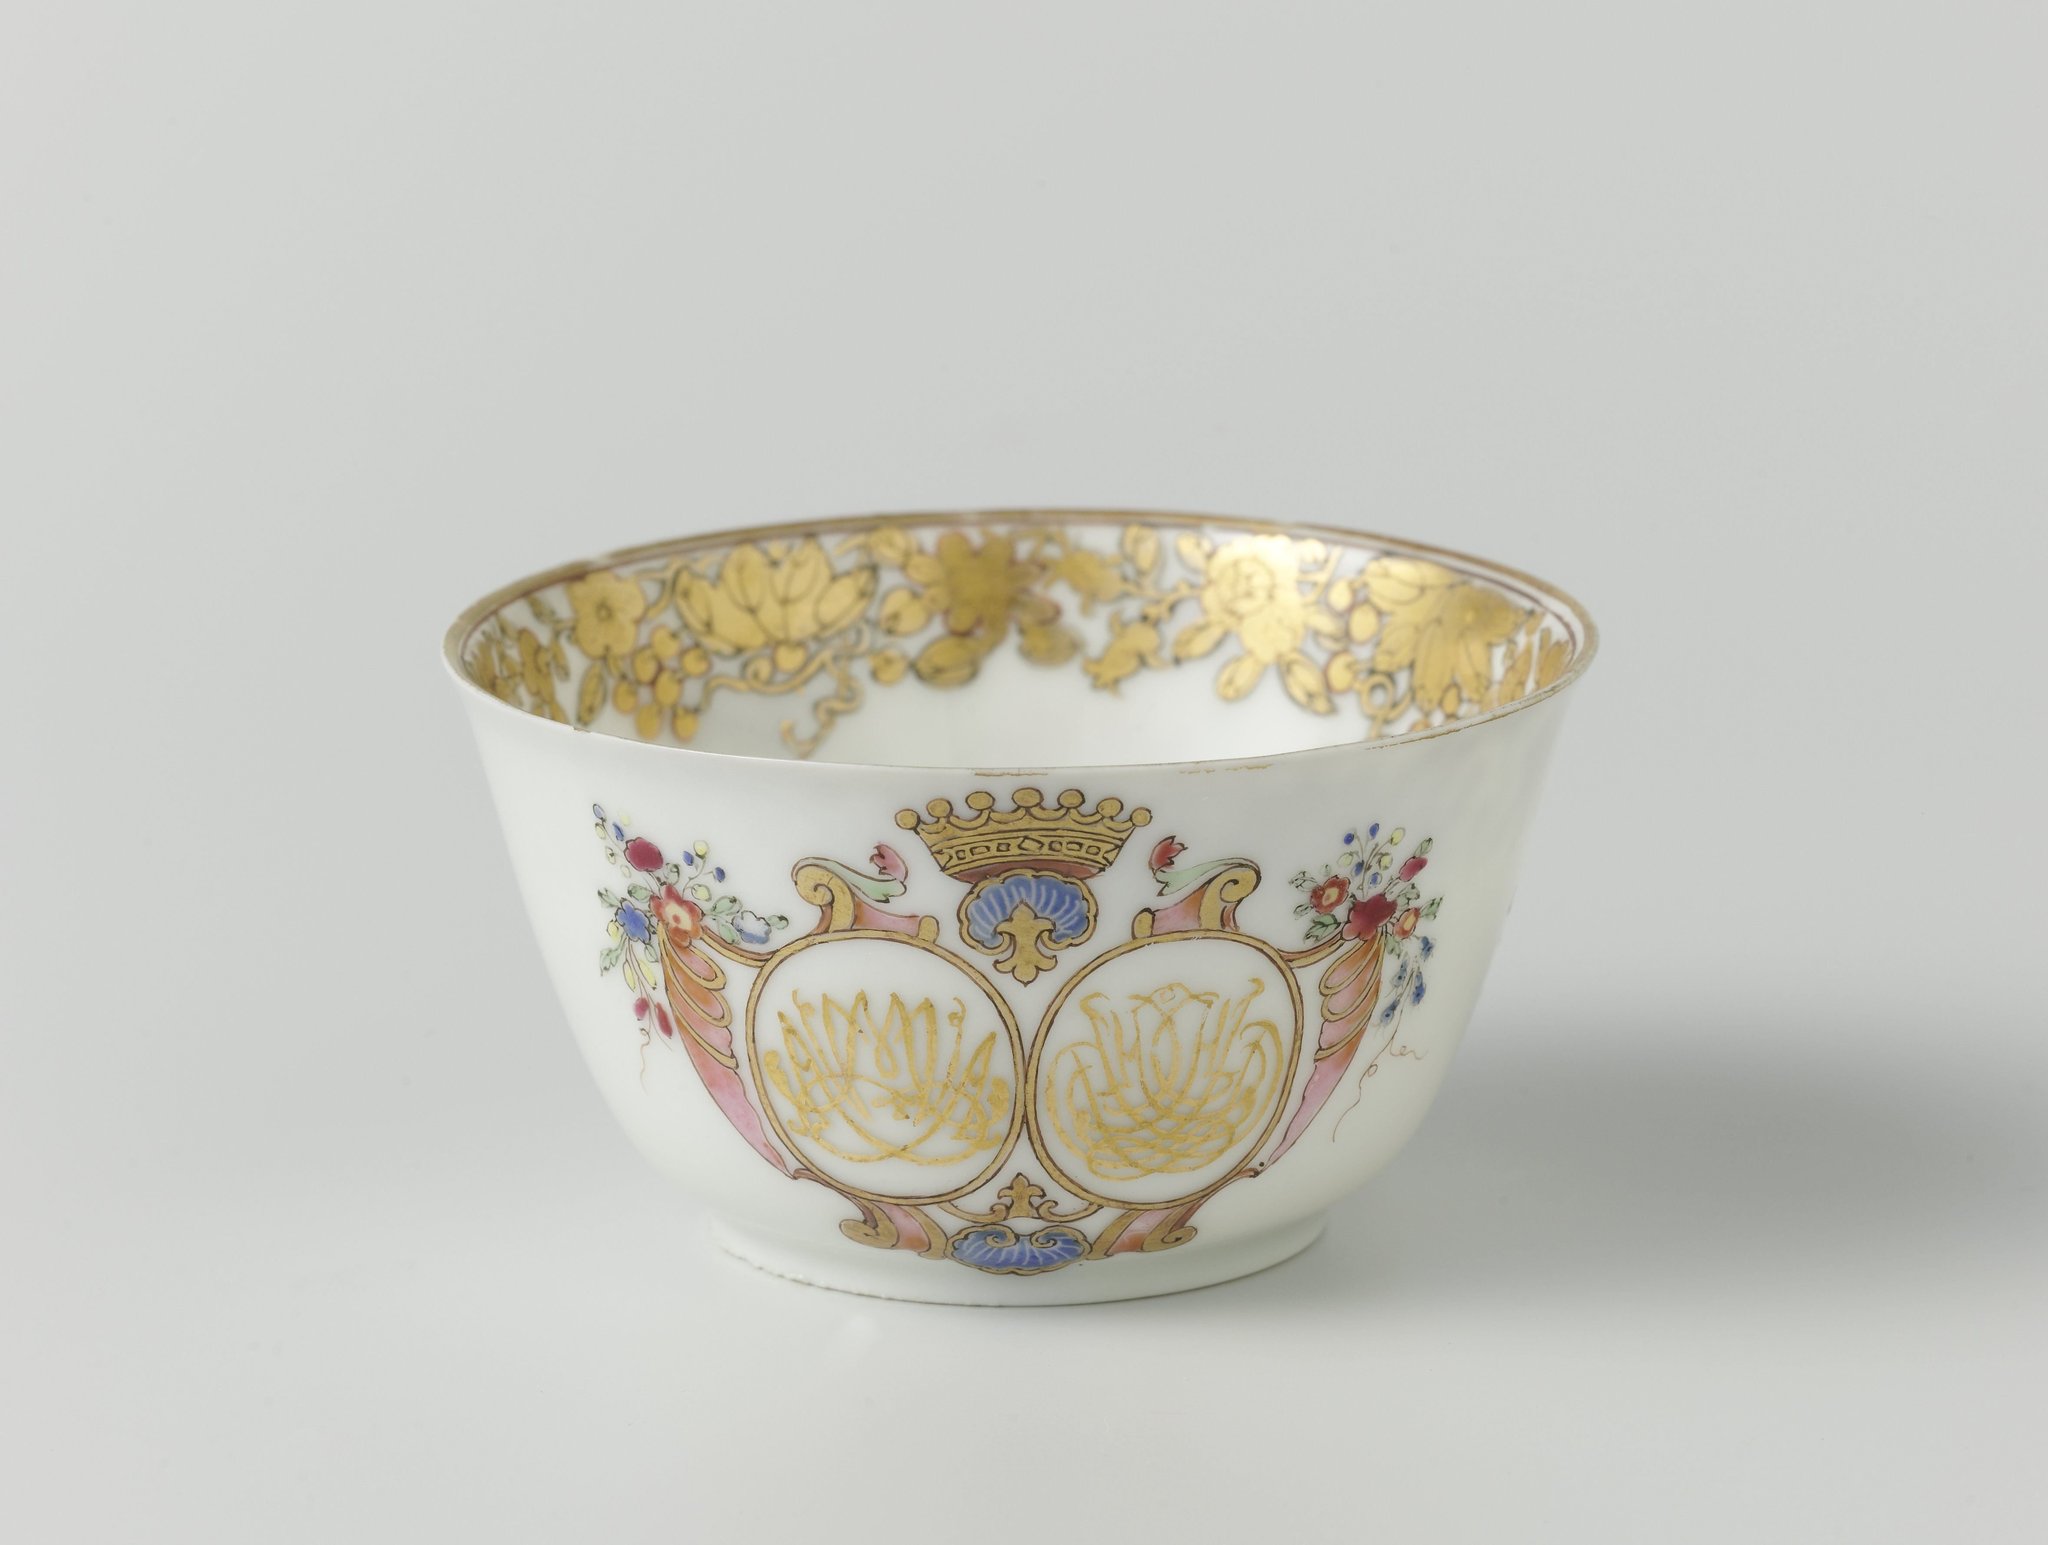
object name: tea cup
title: Bell-shaped cup from the 'Swellengrebel service' with a double crowned monogram and a border with floral scrolls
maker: Anonymous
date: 1740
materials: glaze, gold, paint, porcelain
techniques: firing, gilding, turning, vitrification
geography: china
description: De monogrammen 'MVA' en 'CHTD' staan voor Maurits van Aerden (1694-1746) en Constantia Helena ten Damme (1694-1772), getrouwd in 1716. Het servies is waarschijnlijk besteld ter ere van hun vijfentwingtigjarig huwelijksjubileum in 1741. (Campen, Jan van & Hartkamp-Jonxis, Ebeltje, Aziatische weelde : VOC-kunst in het Rijksmuseum, Zutphen 2011, p. 78)